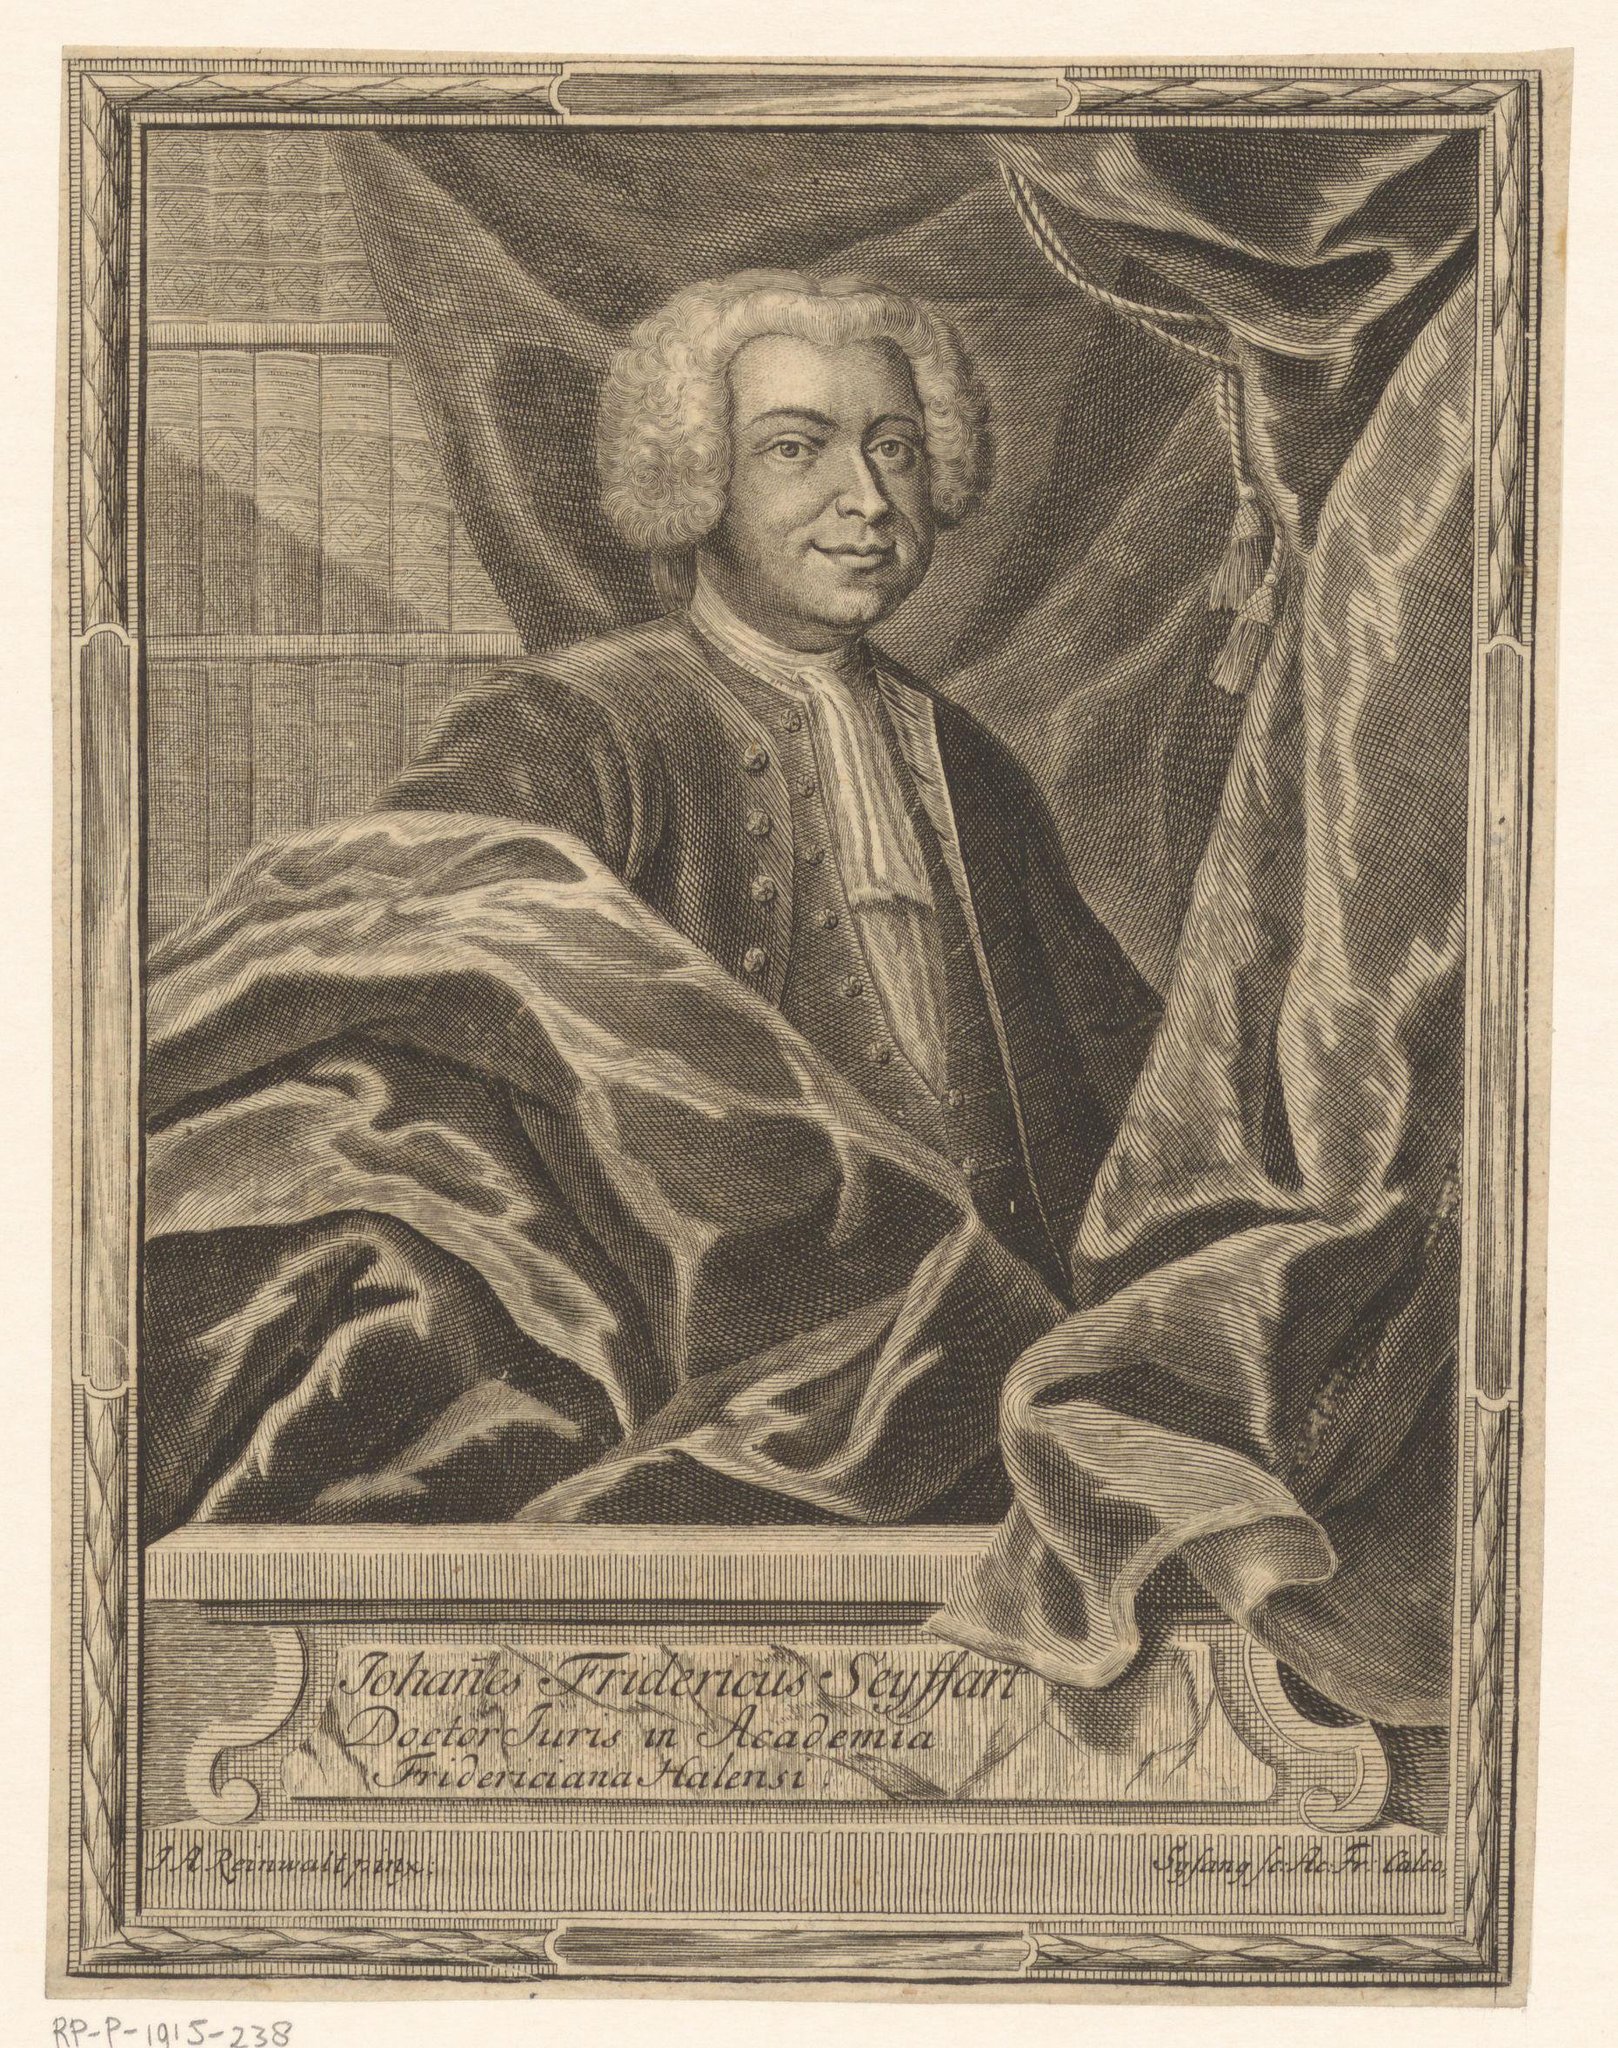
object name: print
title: Portret van Johann Friedrich Seyffart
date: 1721-1757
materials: paper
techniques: engraving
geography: leipzig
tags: bookshelves, historical persons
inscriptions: collector's mark: Lugt 2228